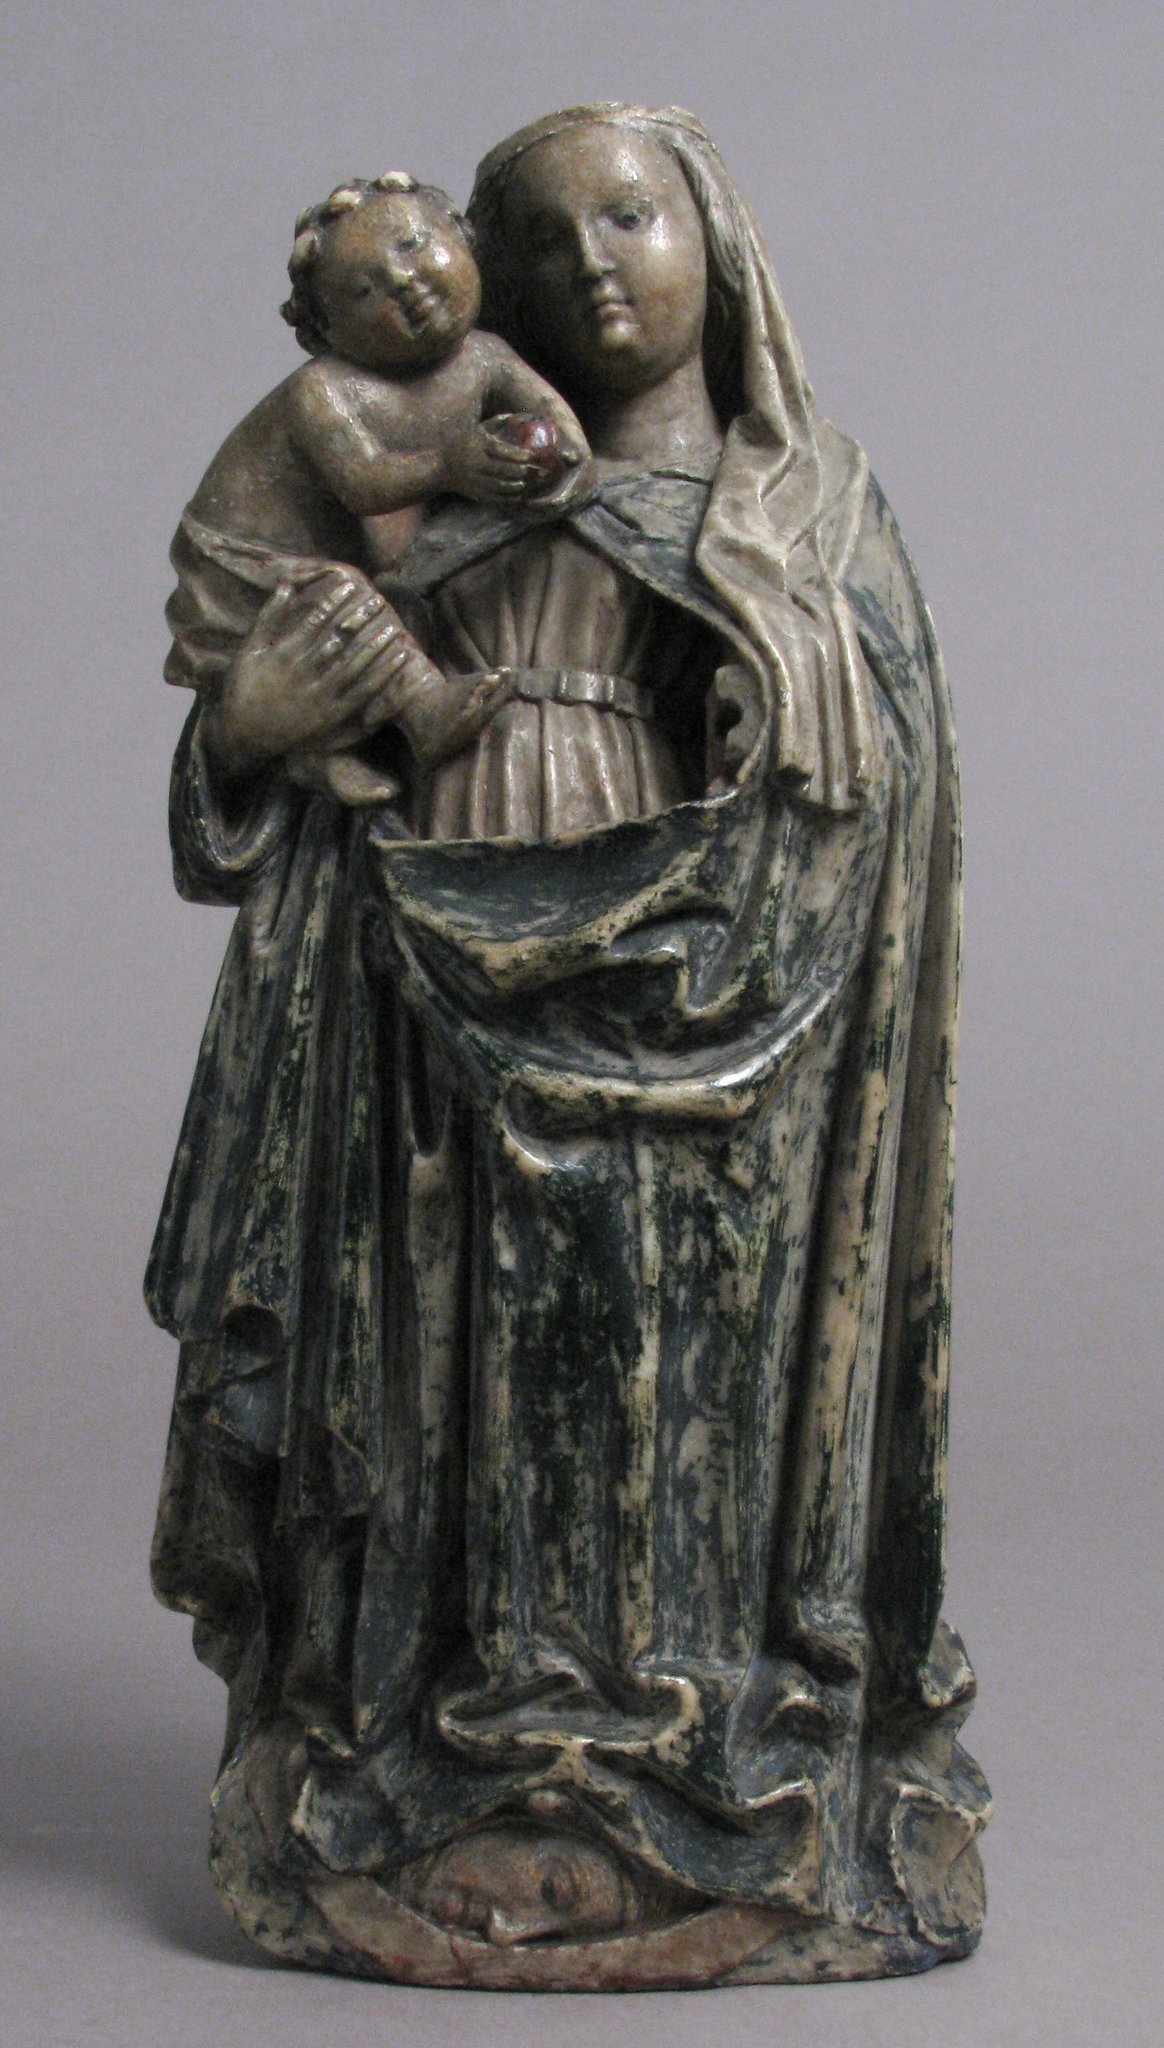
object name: statuette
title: Virgin and Child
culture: south netherlandish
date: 1430-1440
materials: alabaster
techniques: polychromy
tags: madonna and child